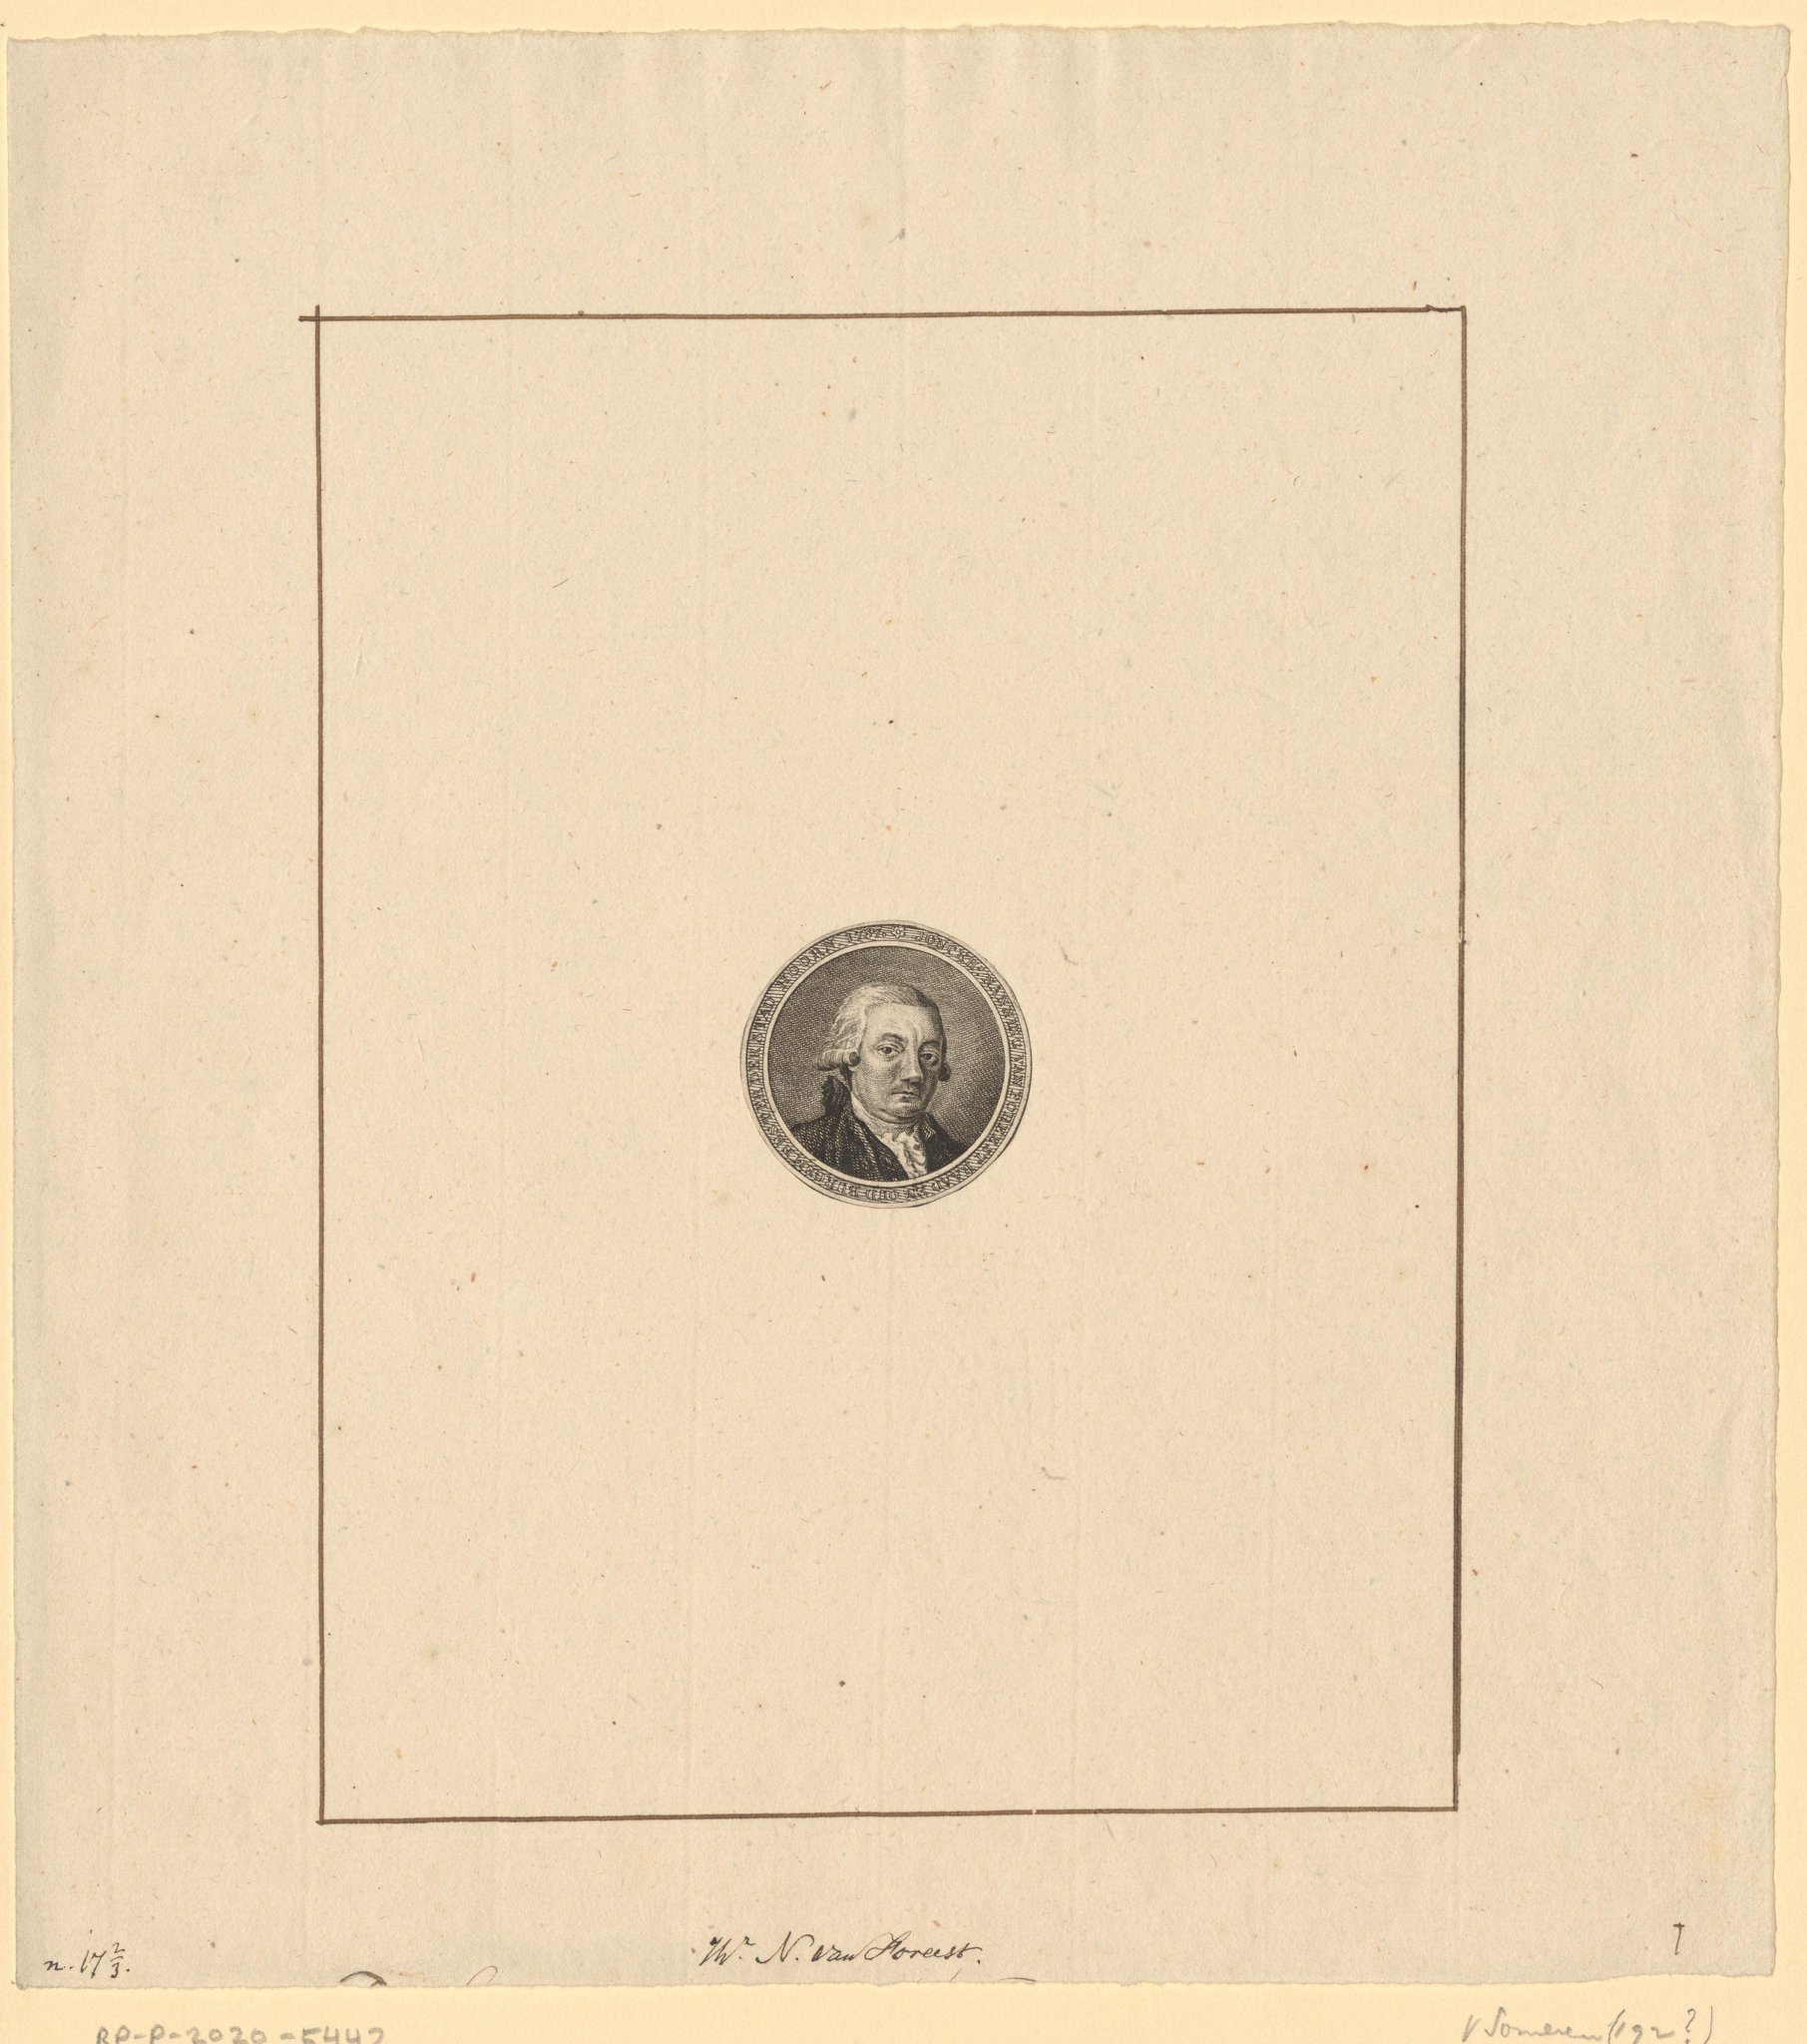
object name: print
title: Portretten van patriotten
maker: abraham jacobsz. hulk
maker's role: print maker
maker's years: 1751-1817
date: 1787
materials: paper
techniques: etching, snipping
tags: historical persons, politician, e.g. party leader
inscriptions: date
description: De plaat van deze prent werd door Jacobus Wijsman aangepast en hergebruikt in zijn eigen serie patriottenportretten. Zie Atlas van Stolk en Van Someren.